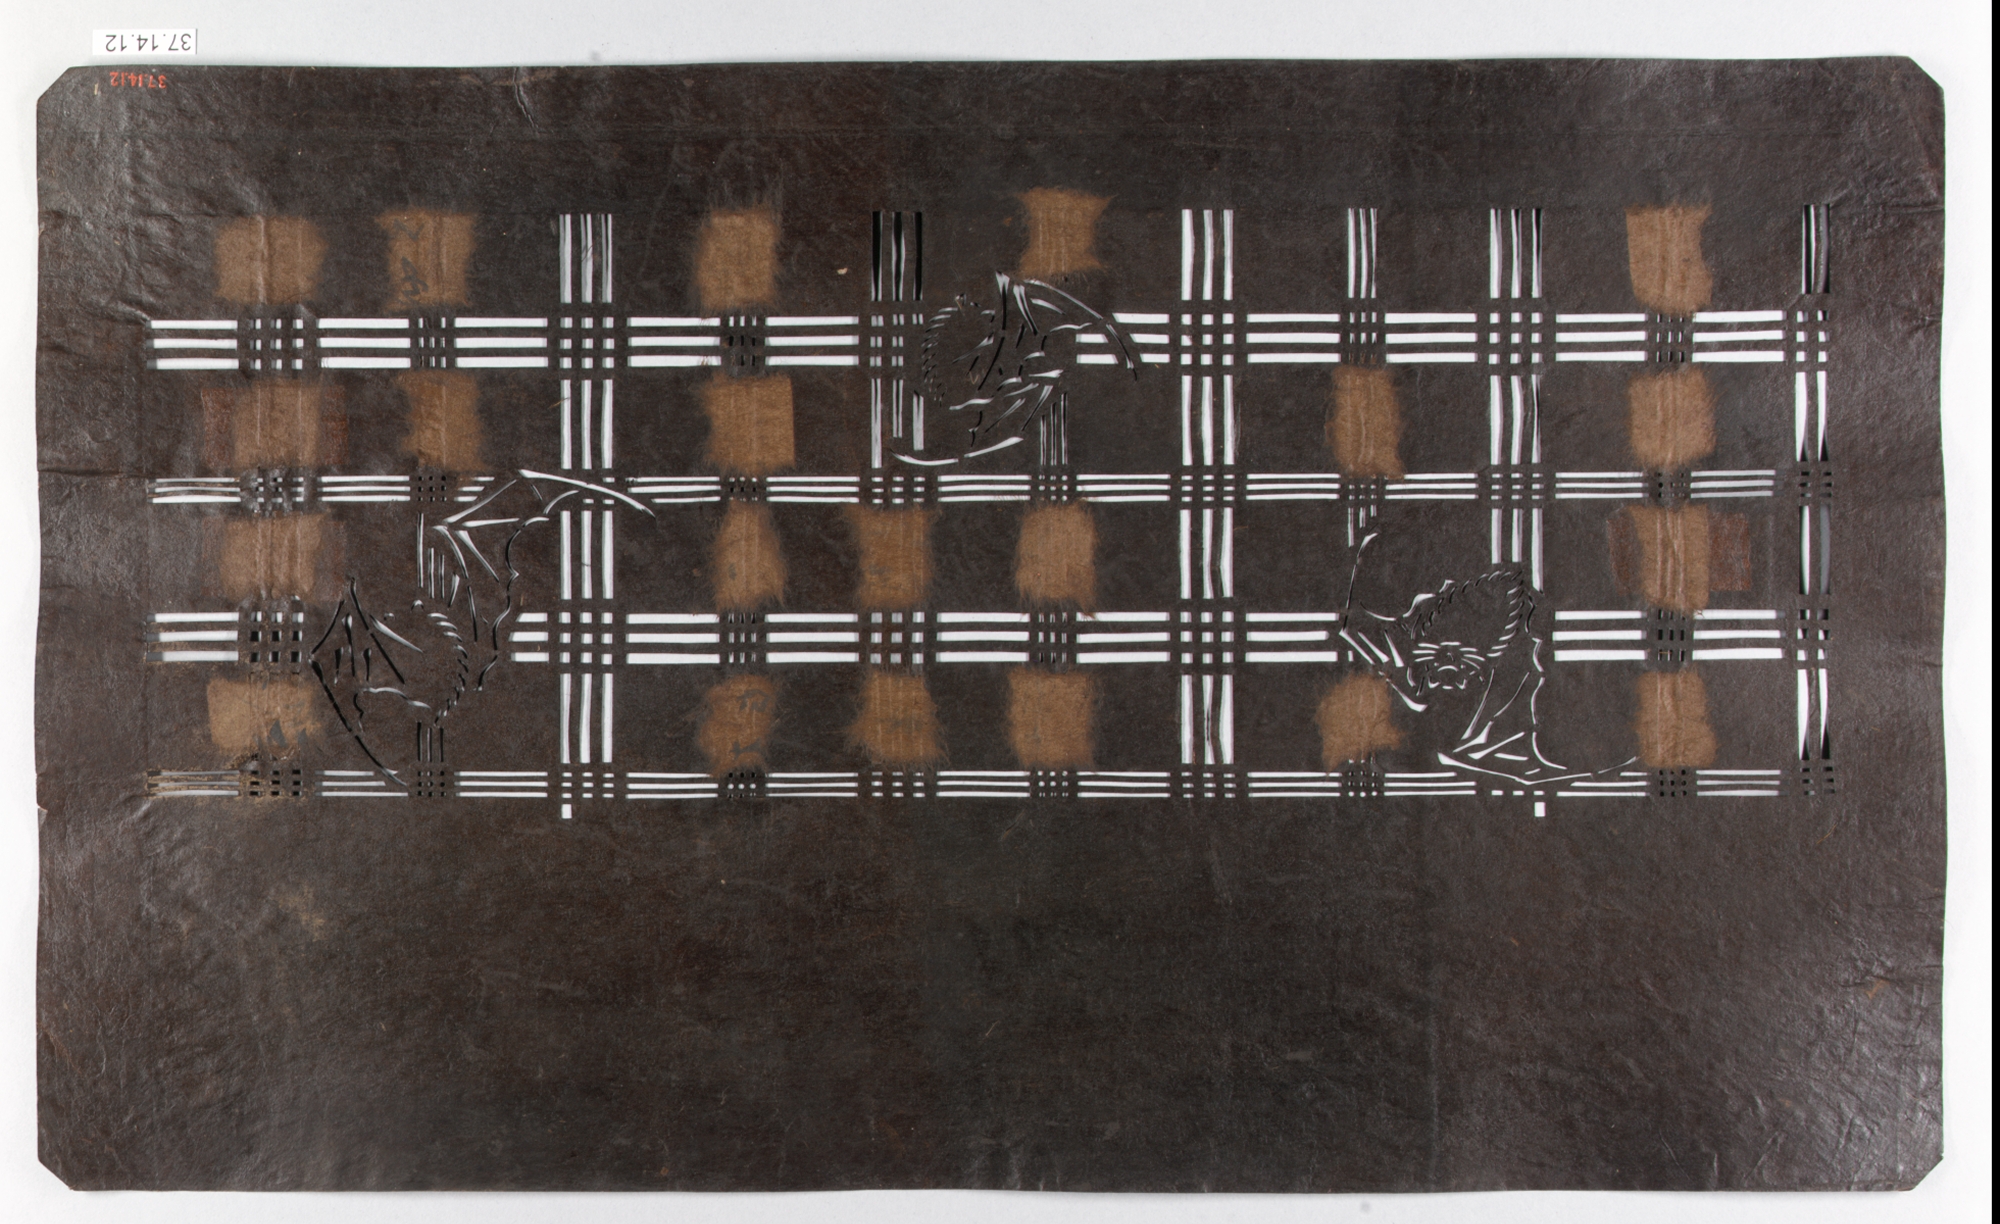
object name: stencil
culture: japanese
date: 1801-1833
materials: paper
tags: bats